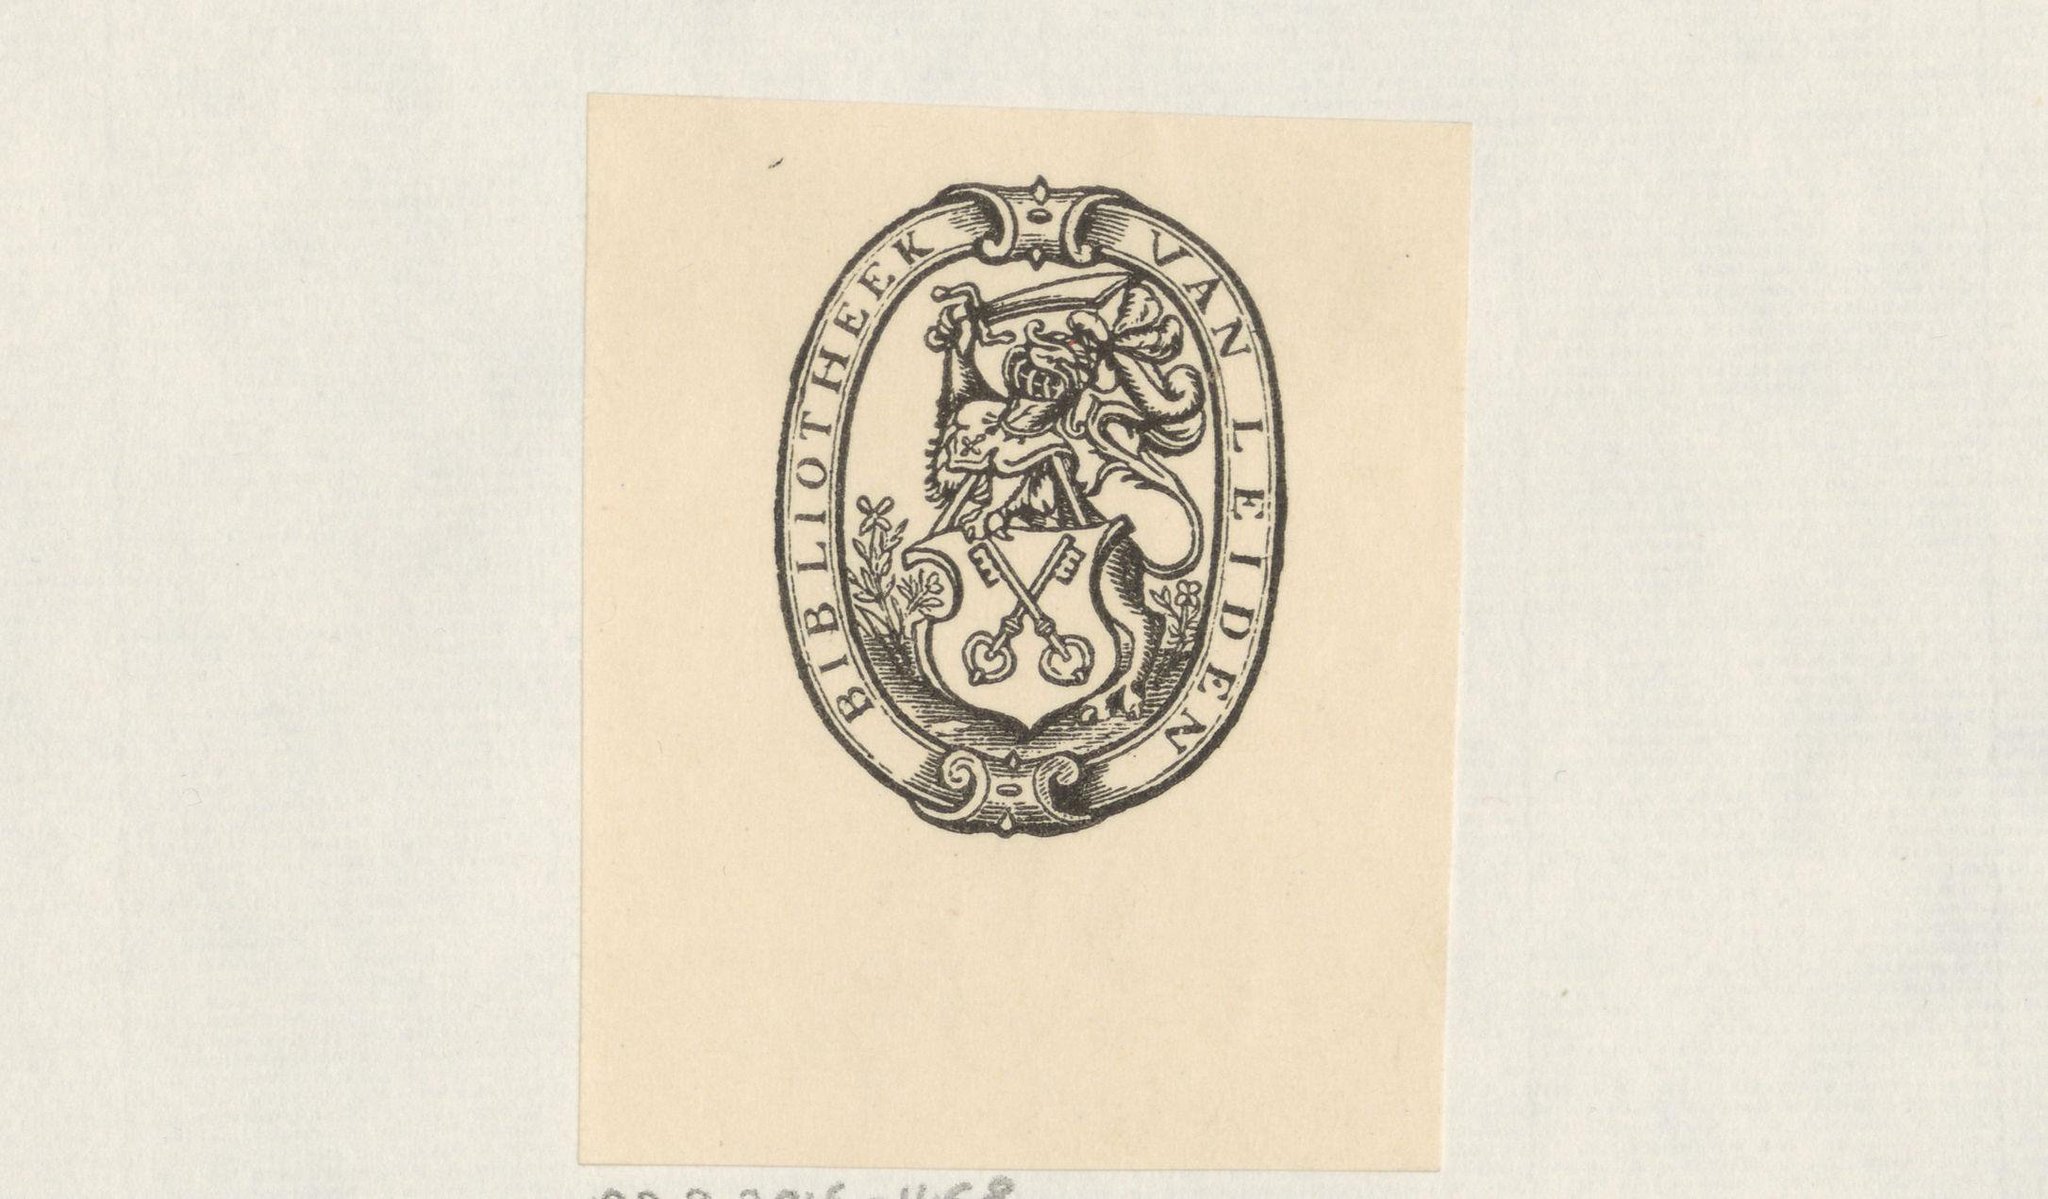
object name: bookplate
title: Ex libris van de Bibliotheek Leiden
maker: Anonymous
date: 1900-1949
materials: paper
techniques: printing block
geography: leiden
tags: armorial bearing, heraldry